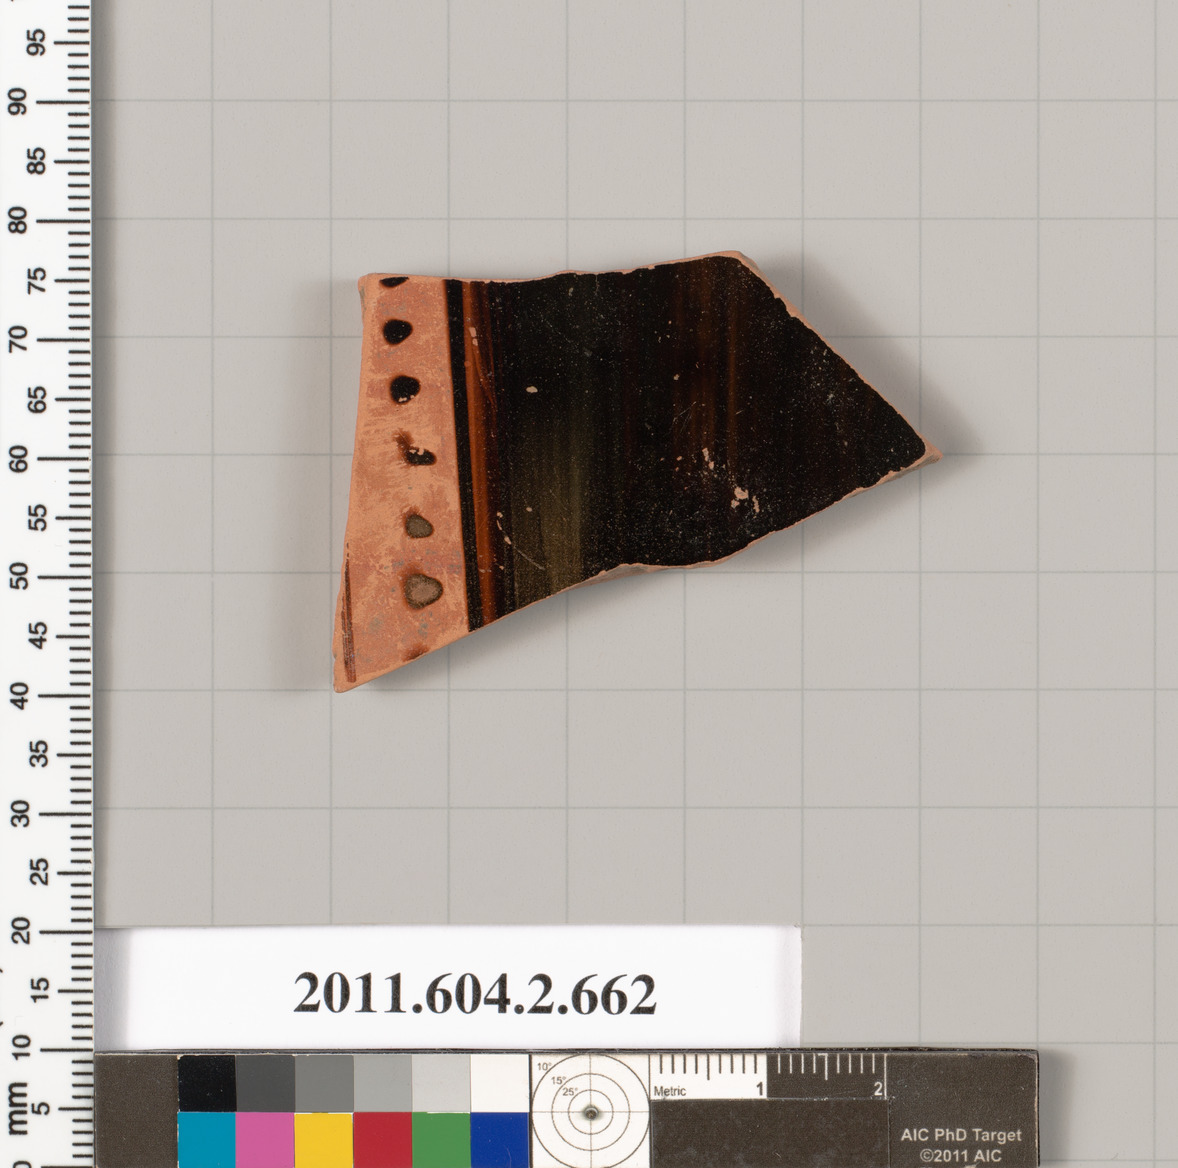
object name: column krater fragment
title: Terracotta fragment of a column-krater (bowl for mixing wine and water)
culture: greek, attic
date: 460-440 BCE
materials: terracotta